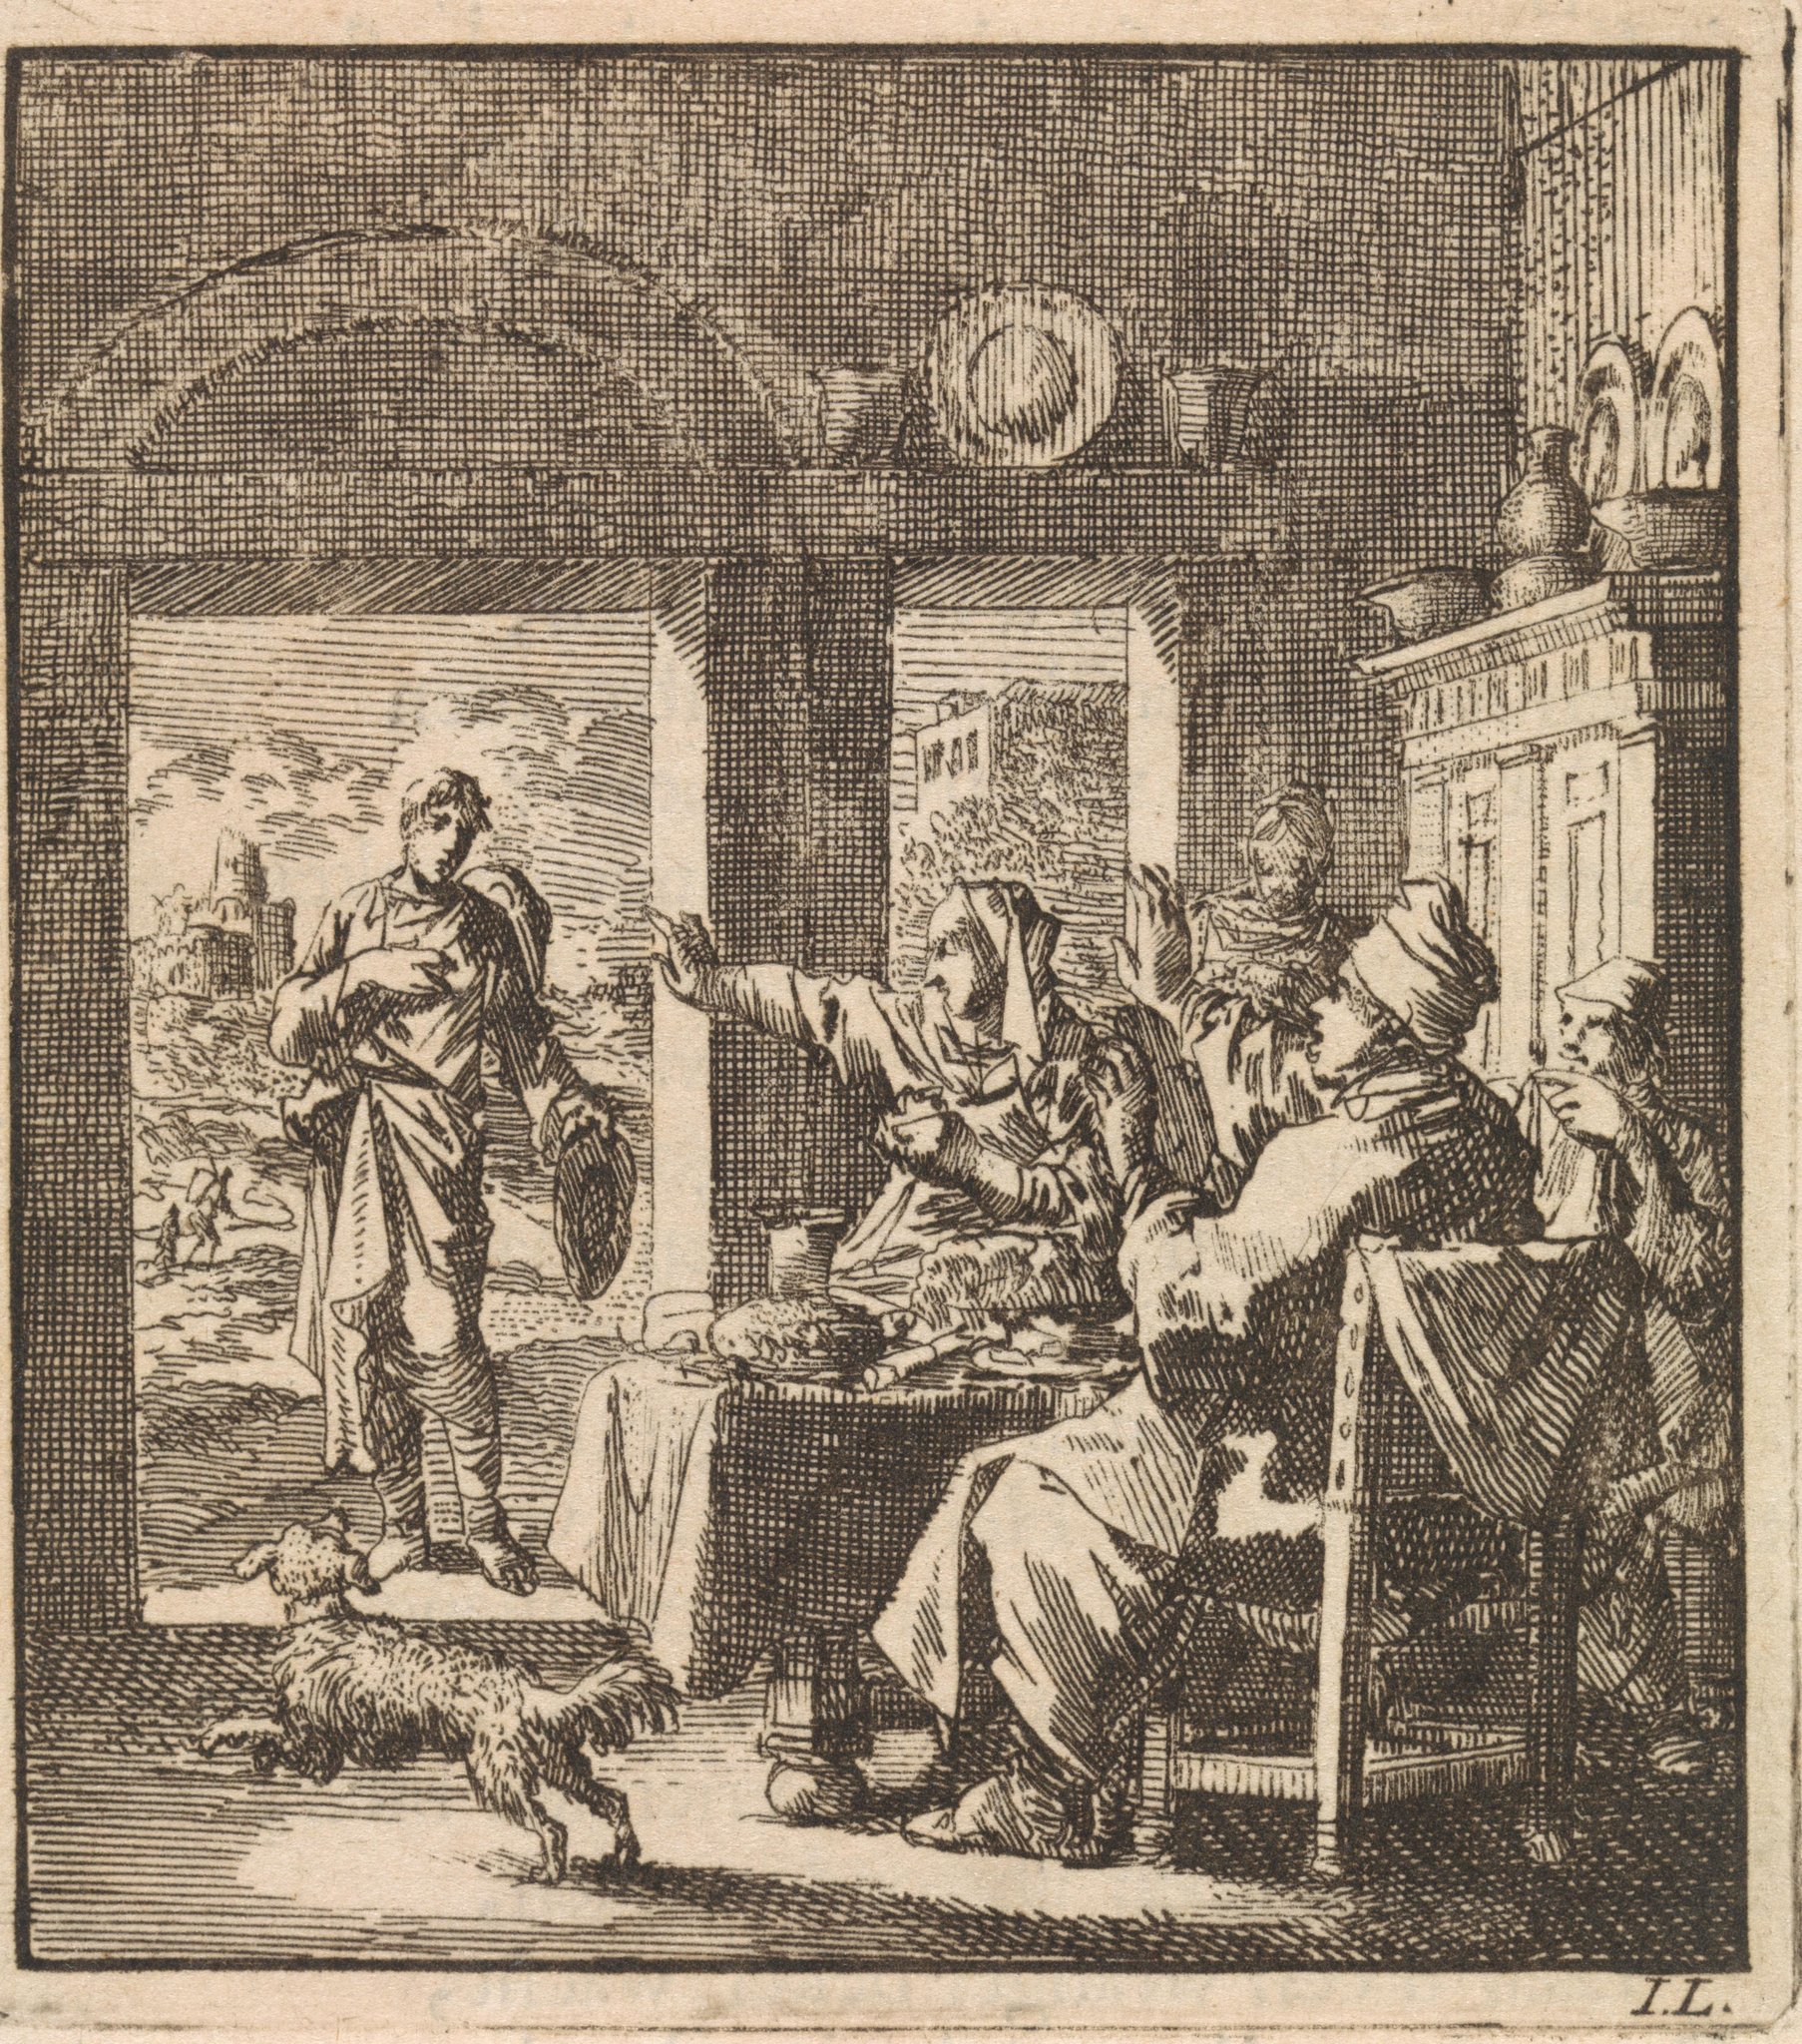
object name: book illustration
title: Tafelend gezin maakt afwijzende gebaren naar een arme man die om hulp vraagt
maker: jan luyken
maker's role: draughtsman, print maker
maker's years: 1649-1712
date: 1711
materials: paper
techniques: etching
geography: amsterdam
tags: eating, the poor, dog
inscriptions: collector's mark: Lugt 2228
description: Illustratie voor: Spinniker, Adriaan. De werken en vergelding der barmhertigheid, en onbarmhertigheid. Amsterdam: Pieter Arentsz. II (wed.) en Cornelis van der Sys, 1711, p. 17.